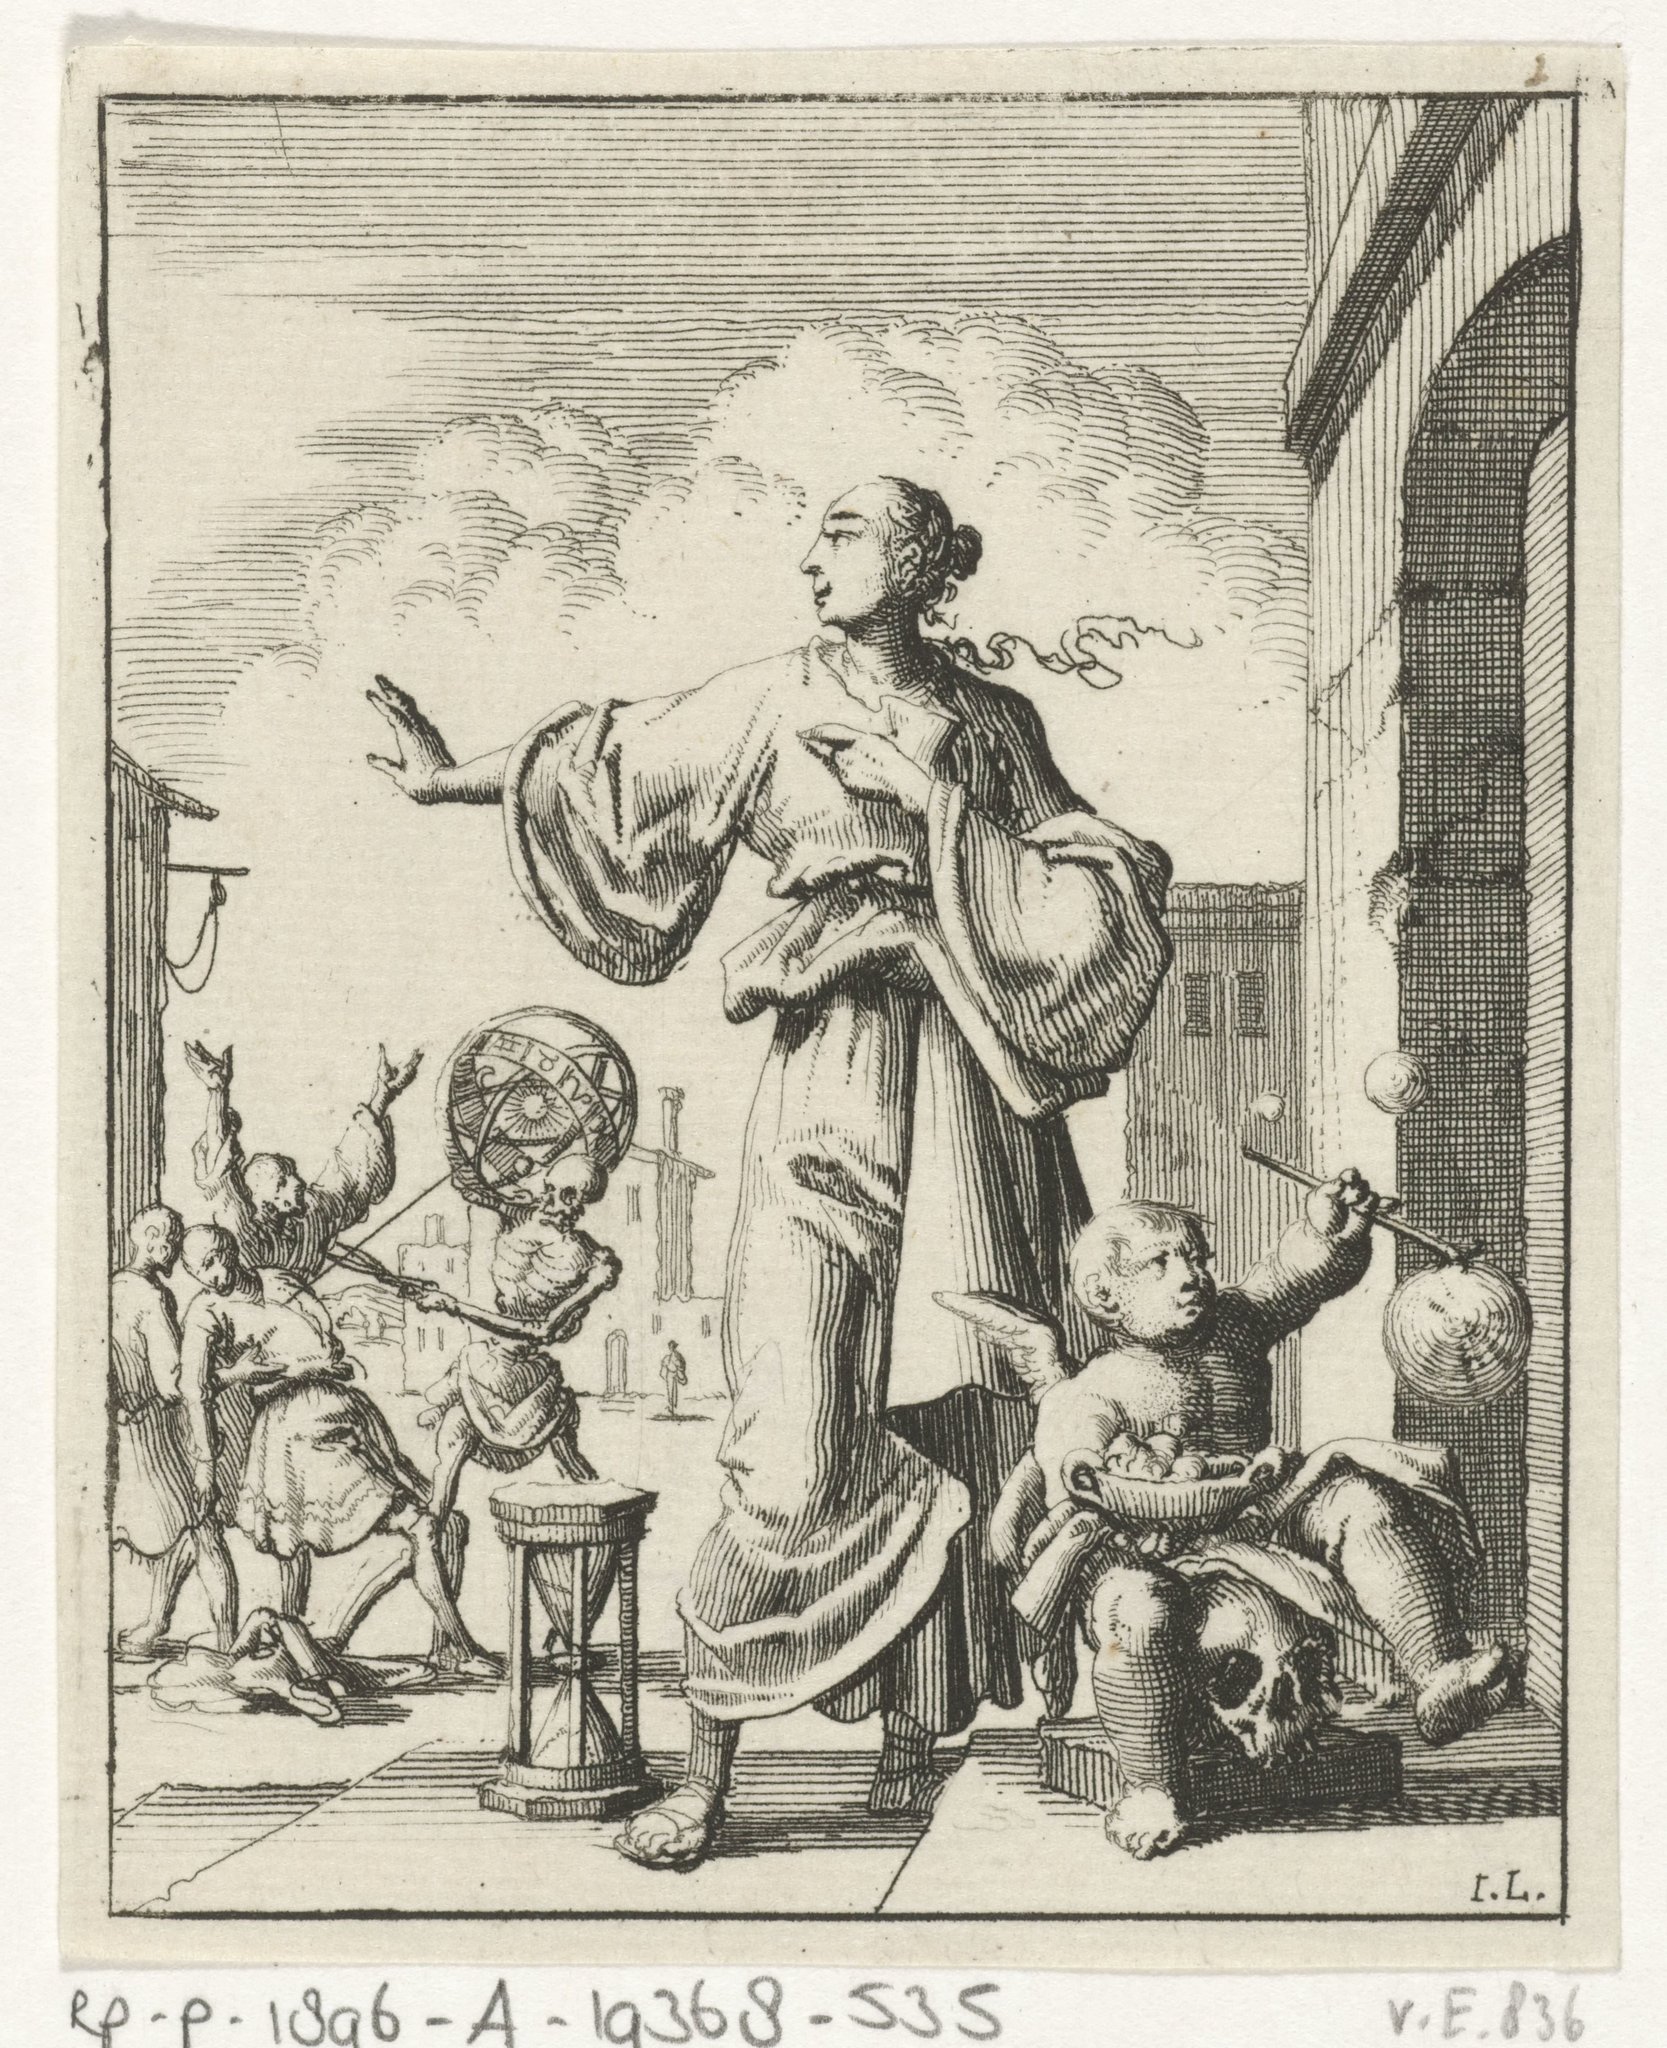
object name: print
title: Vrouw maakt afwerend gebaar naar de Dood die de levensdraad doorknipt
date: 1687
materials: paper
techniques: etching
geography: amsterdam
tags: symbols of human life, (children or putti) blowing bubbles, 'homo bulla' ~ scene symbolizing 'vanitas', death as skeleton - ff - death as female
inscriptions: collector's mark: Lugt 2228, number: ‘1’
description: Illustratie uit: Luyken, Jan. Voncken der liefde Jesu, van het godtbegerende zielenvier. Amsterdam: Pieter Arentsz (II), 1687, p. 2.